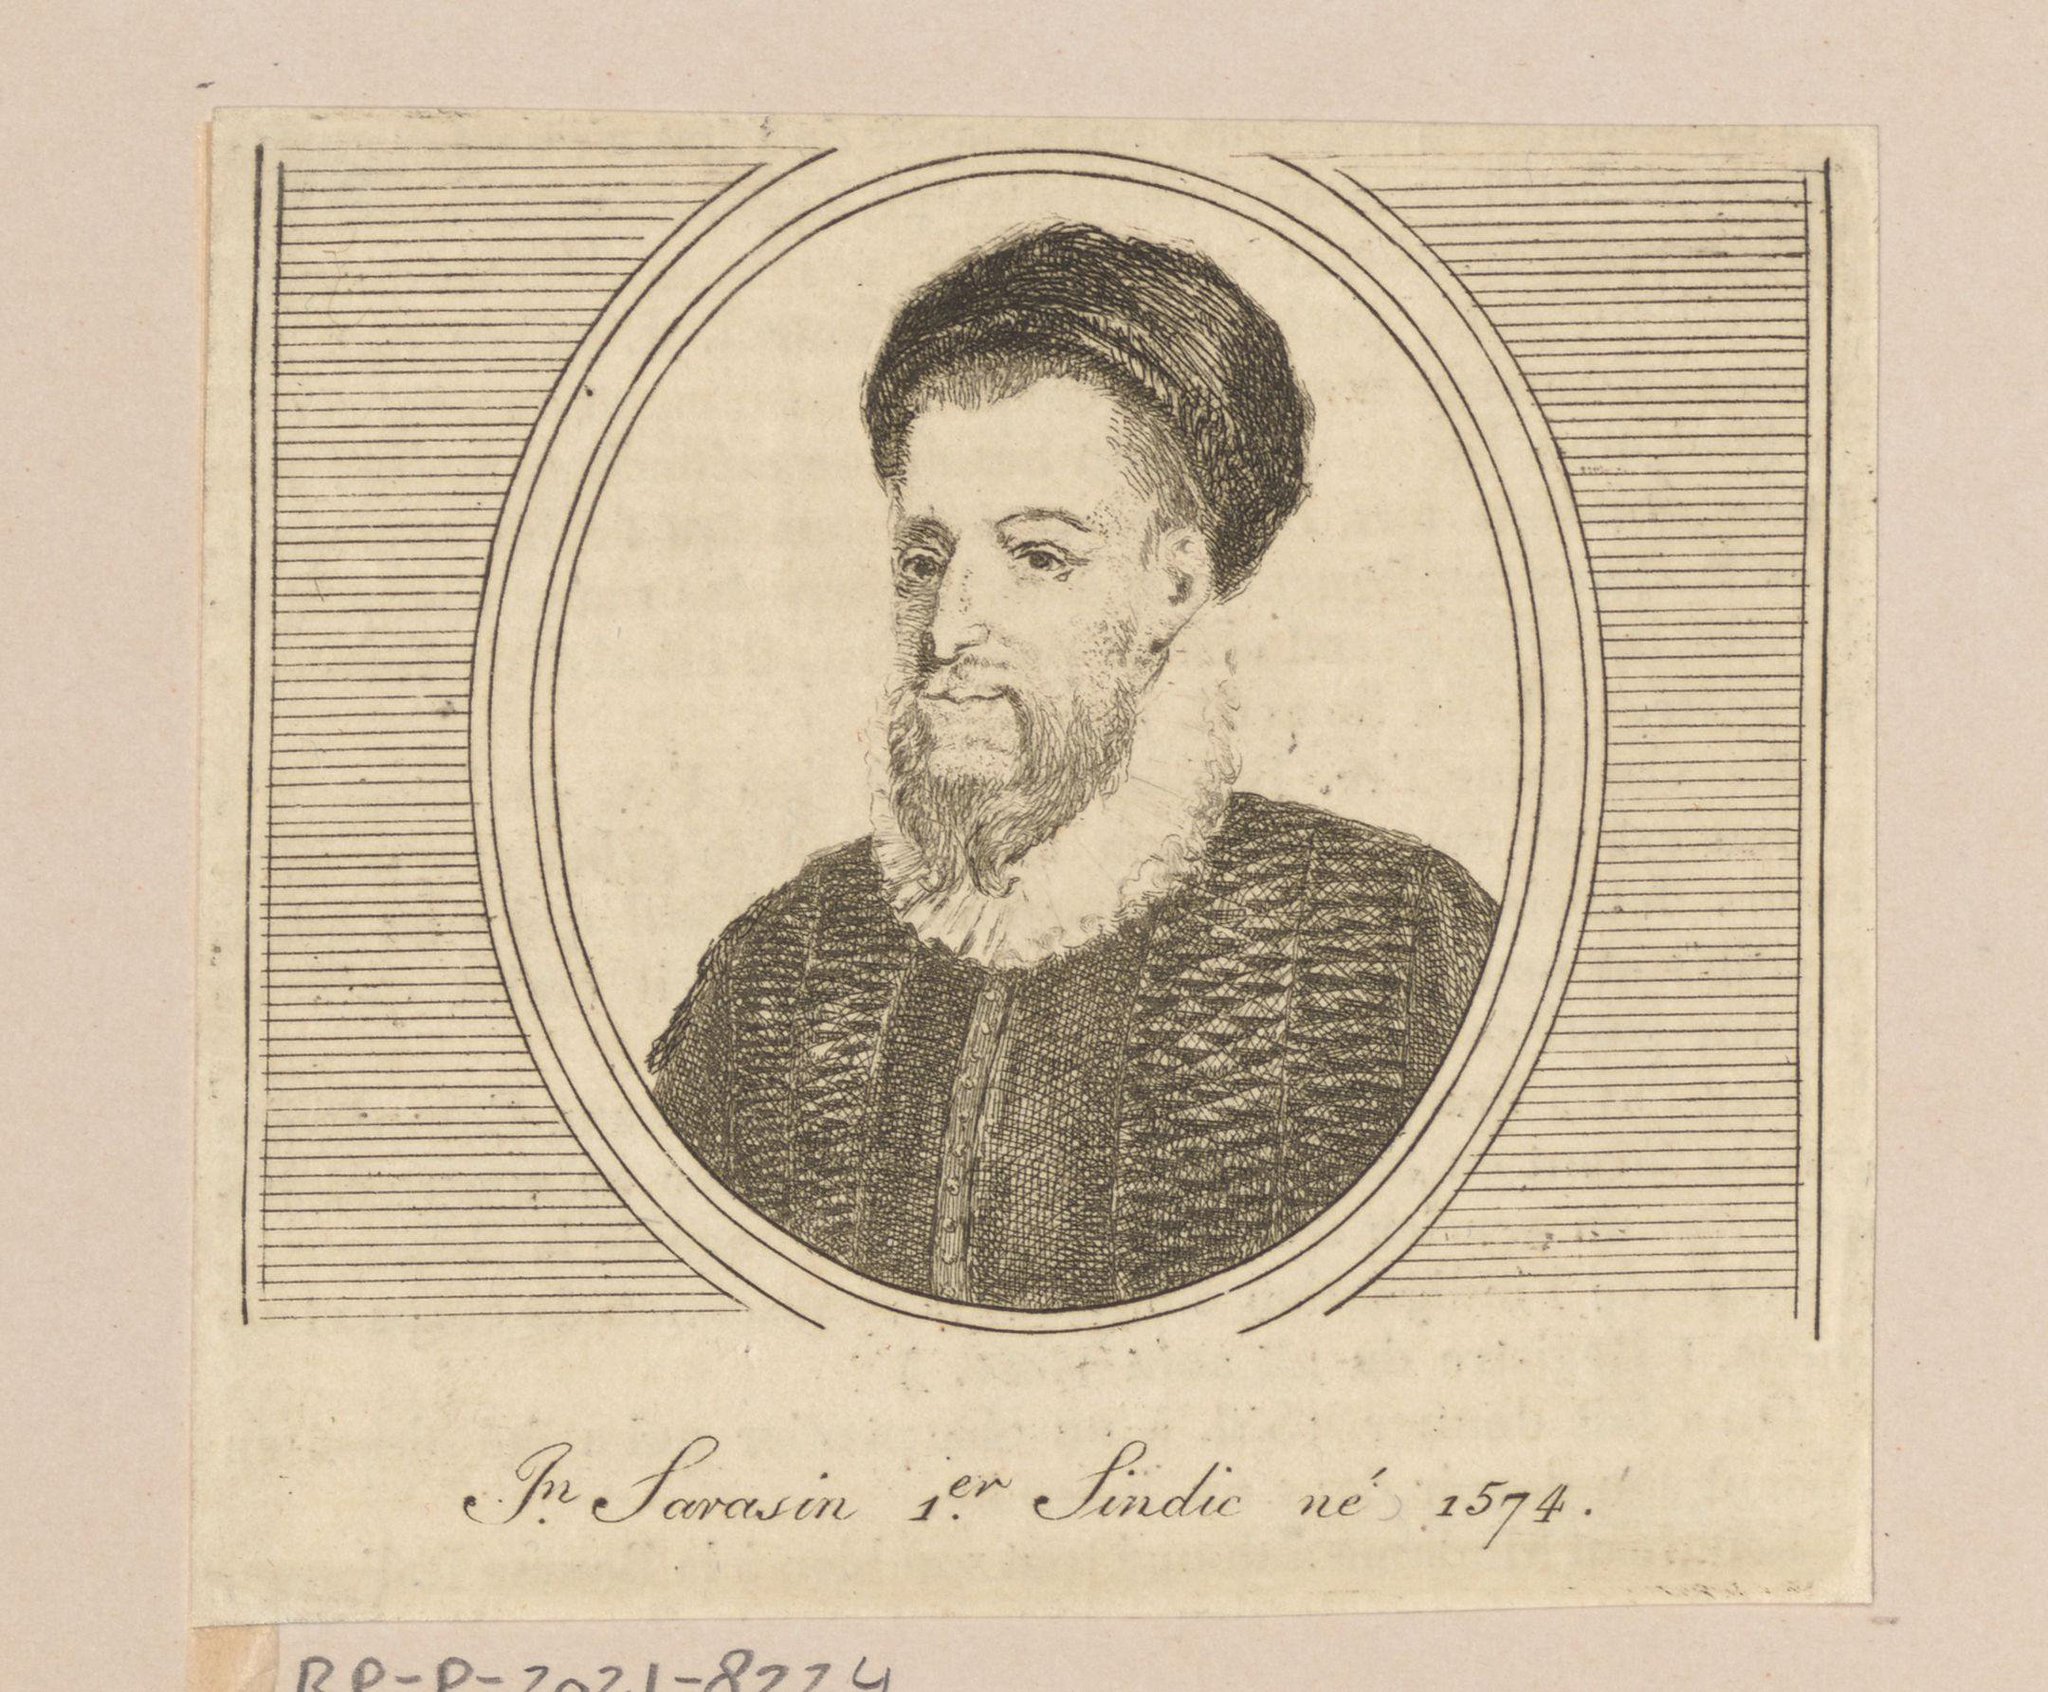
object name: book illustration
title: Portret van Jean Sarasin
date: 1815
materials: paper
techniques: etching, letterpress printing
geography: geneva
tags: historical persons, politician, e.g. party leader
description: Prent uit: Grenus, Théodore de. Fragmens biographiques et historiques. Extraits des registres du Conseil (...). Genève: Manget et Cherbuliez, 1815.